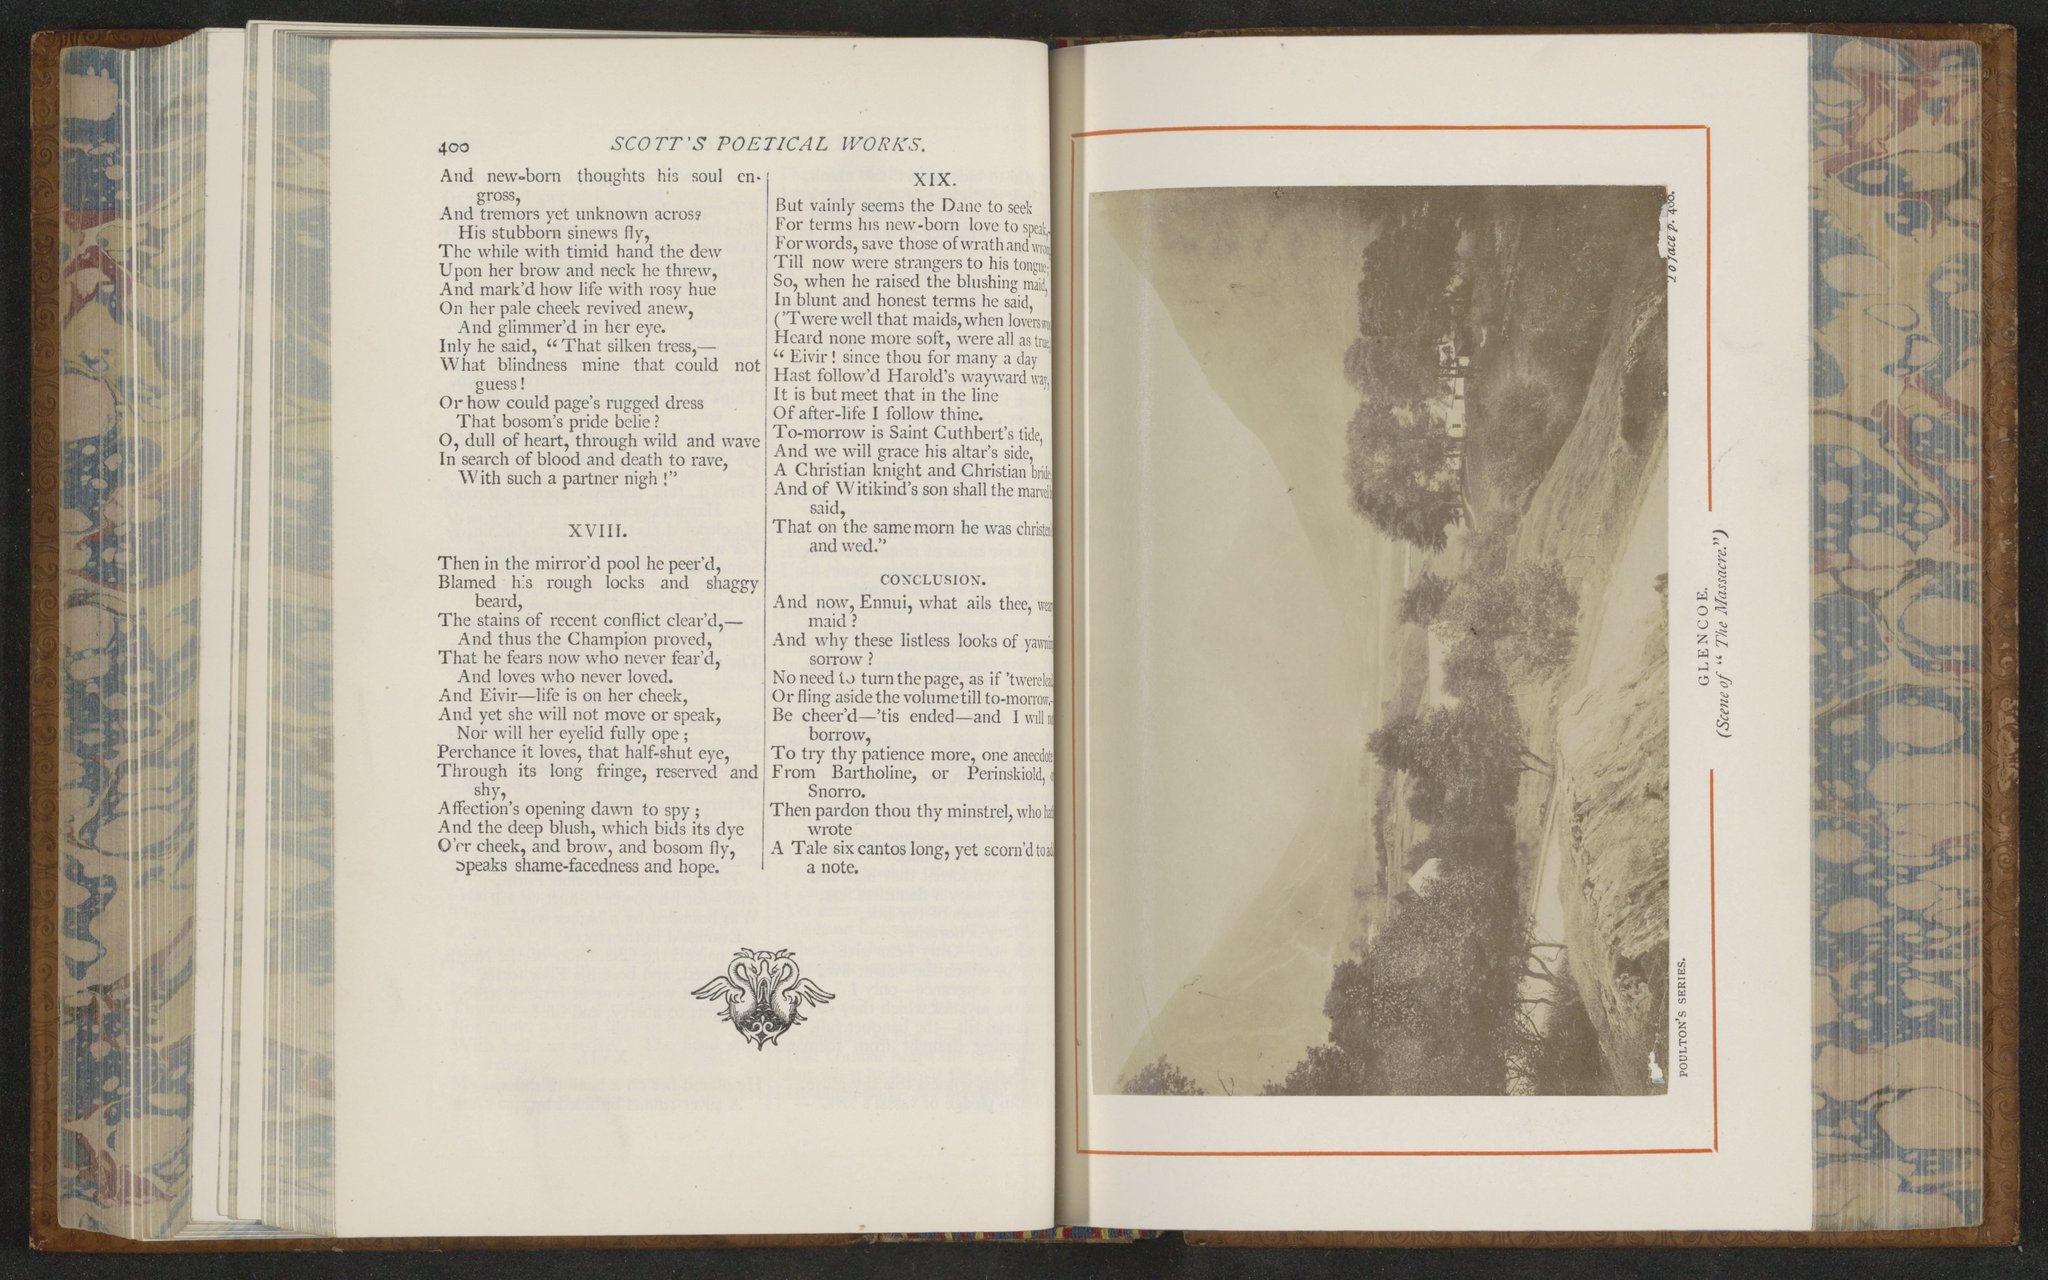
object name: page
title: Gezicht op het landschap bij Glencoe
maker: Anonymous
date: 1880-1890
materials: photographic support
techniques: albumen print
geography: glen coe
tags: landscapes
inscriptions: inscription: ‘Poulton's series.’